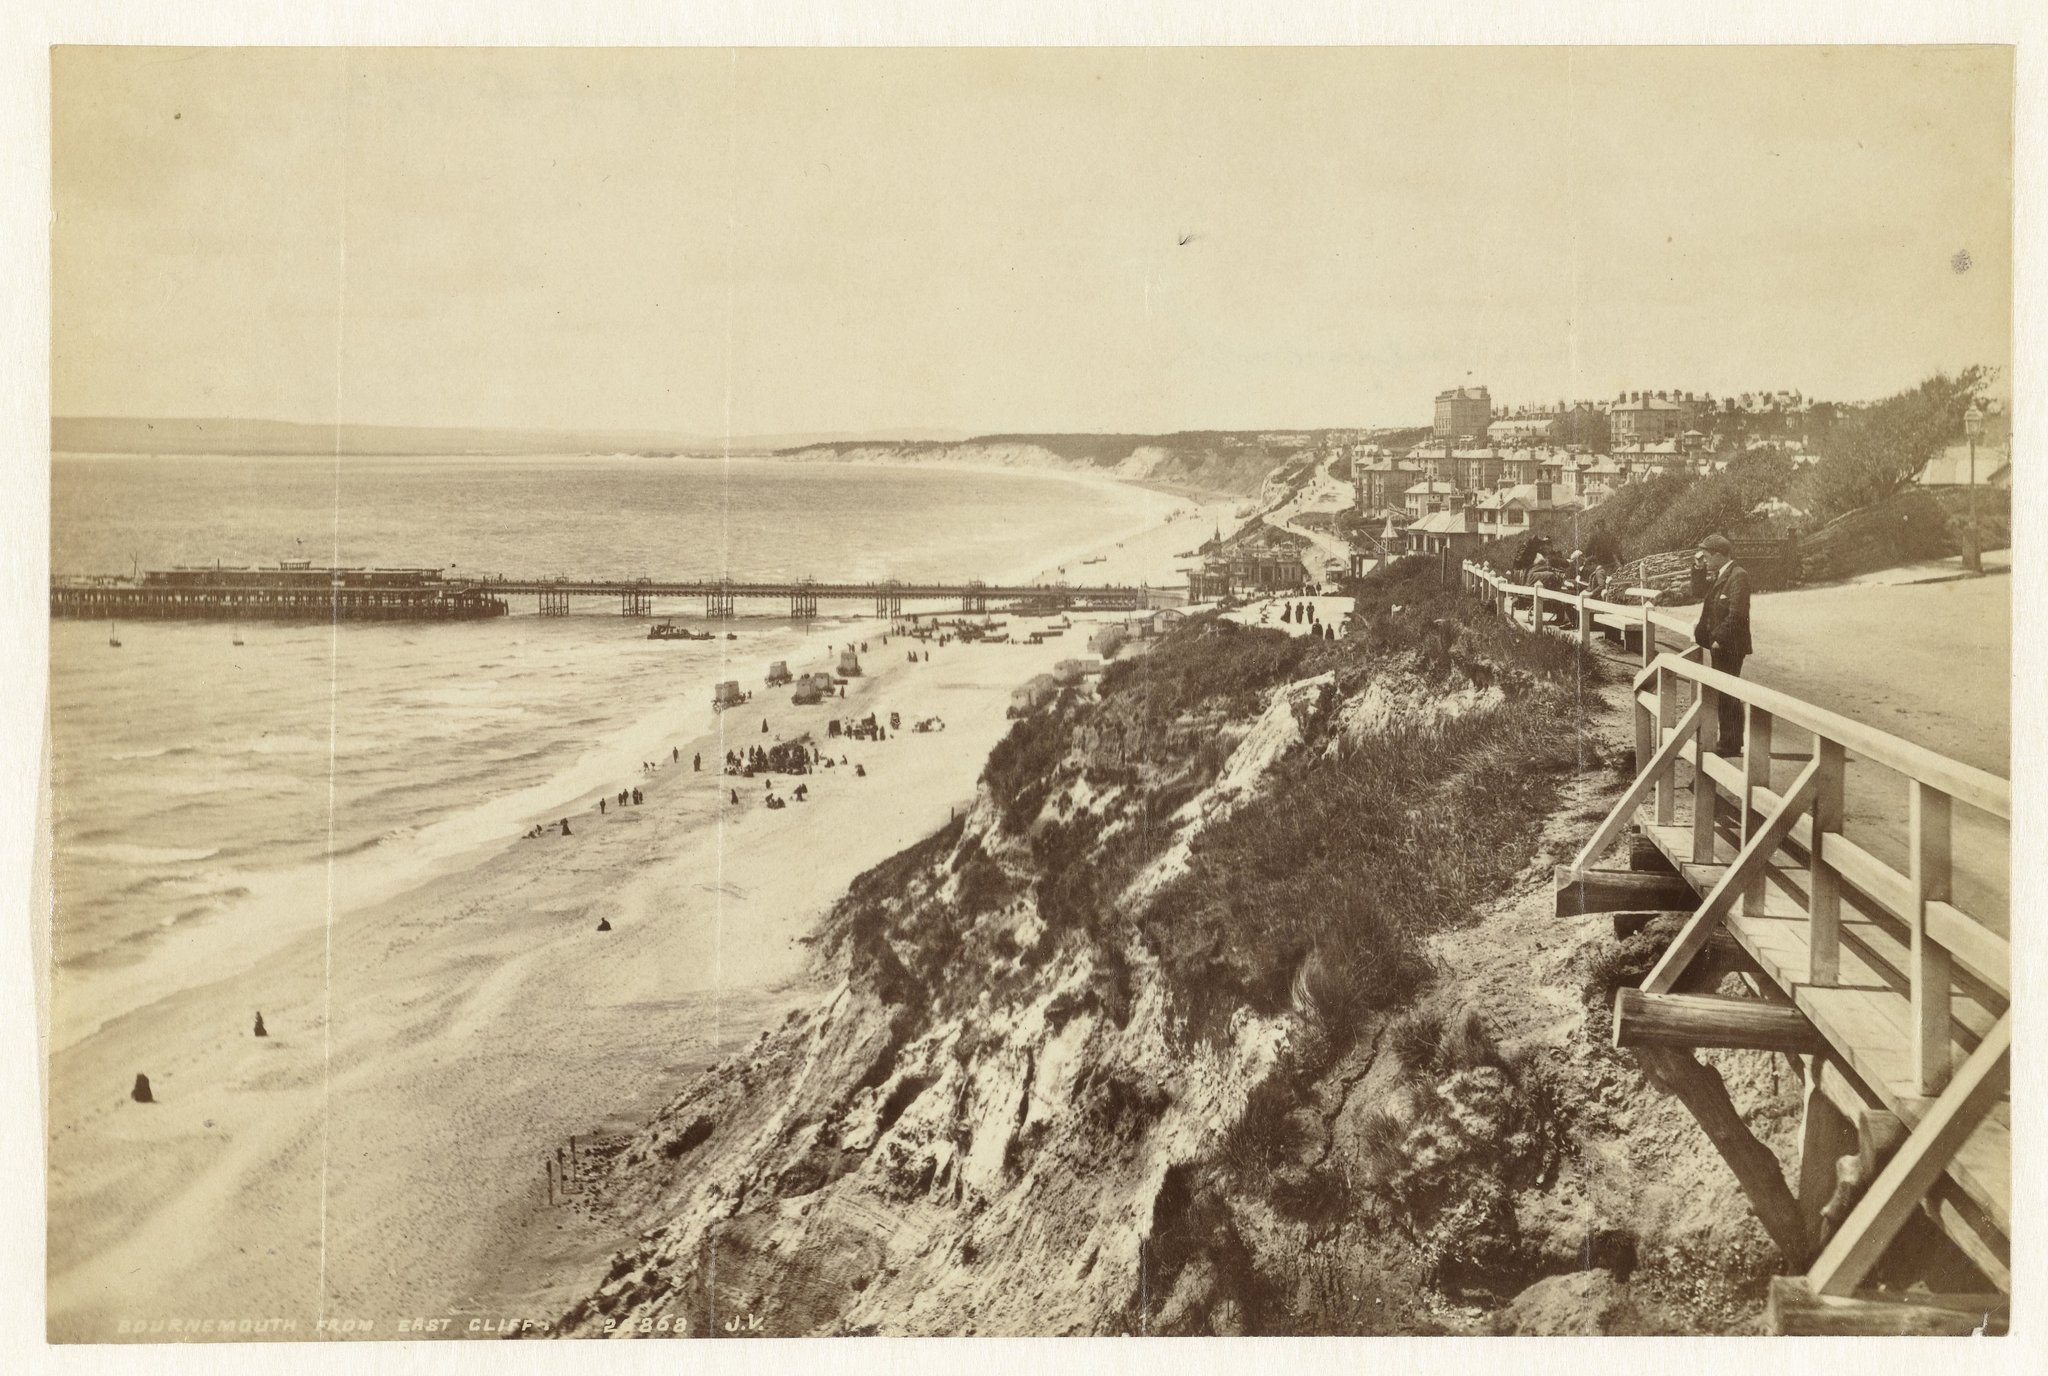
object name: photograph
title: Bournemouth from East Cliff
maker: james valentine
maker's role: fotograaf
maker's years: 1815-1880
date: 1851-1880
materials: paper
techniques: albumen print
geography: bournemouth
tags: pier, quay, wharf, beach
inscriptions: number: ‘20868’